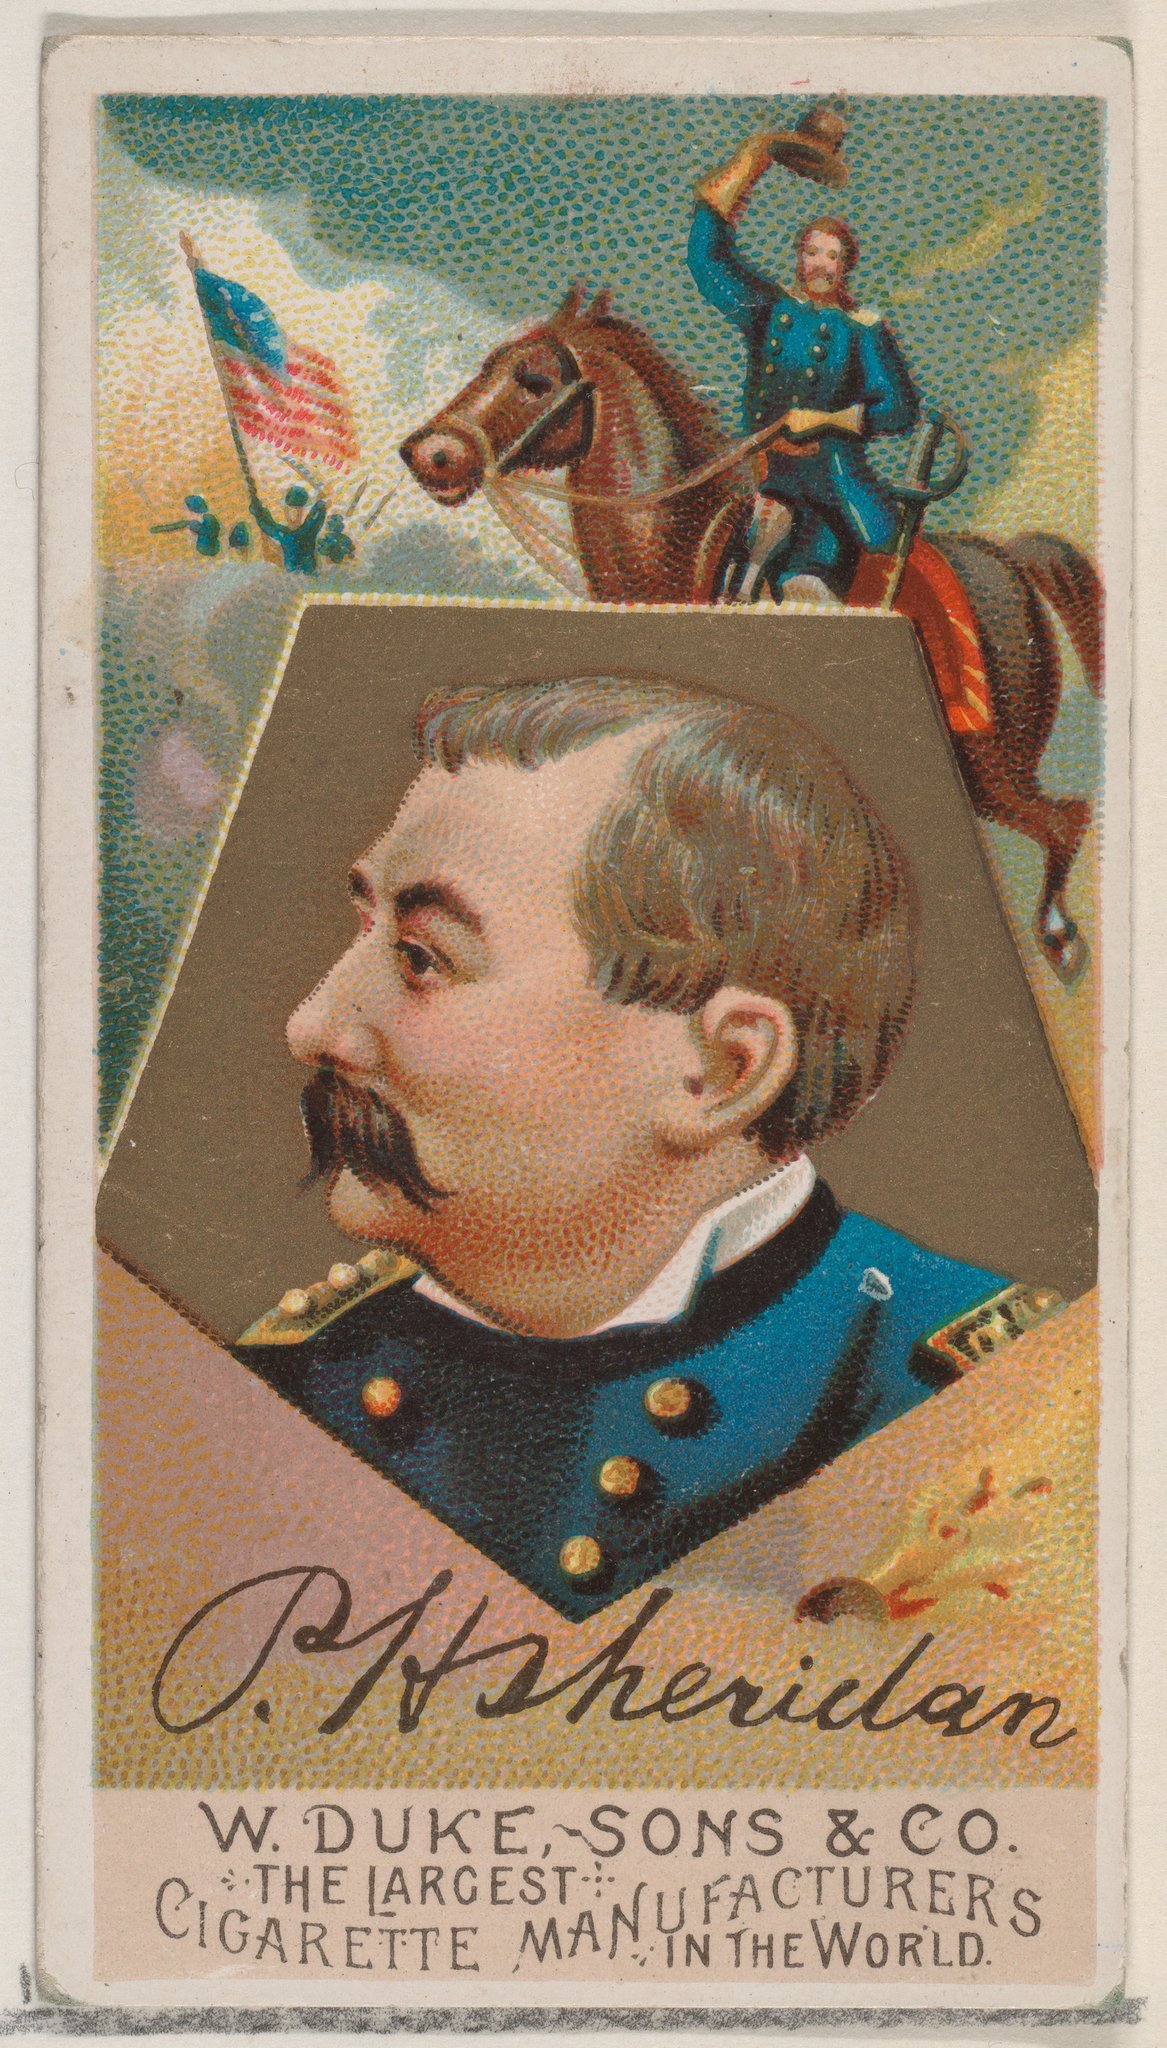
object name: print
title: Philip H. Sheridan, from the series Great Americans (N76) for Duke brand cigarettes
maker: w. duke, sons & co.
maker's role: publisher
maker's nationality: american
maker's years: 1870-1920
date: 1888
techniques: color lithograph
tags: men